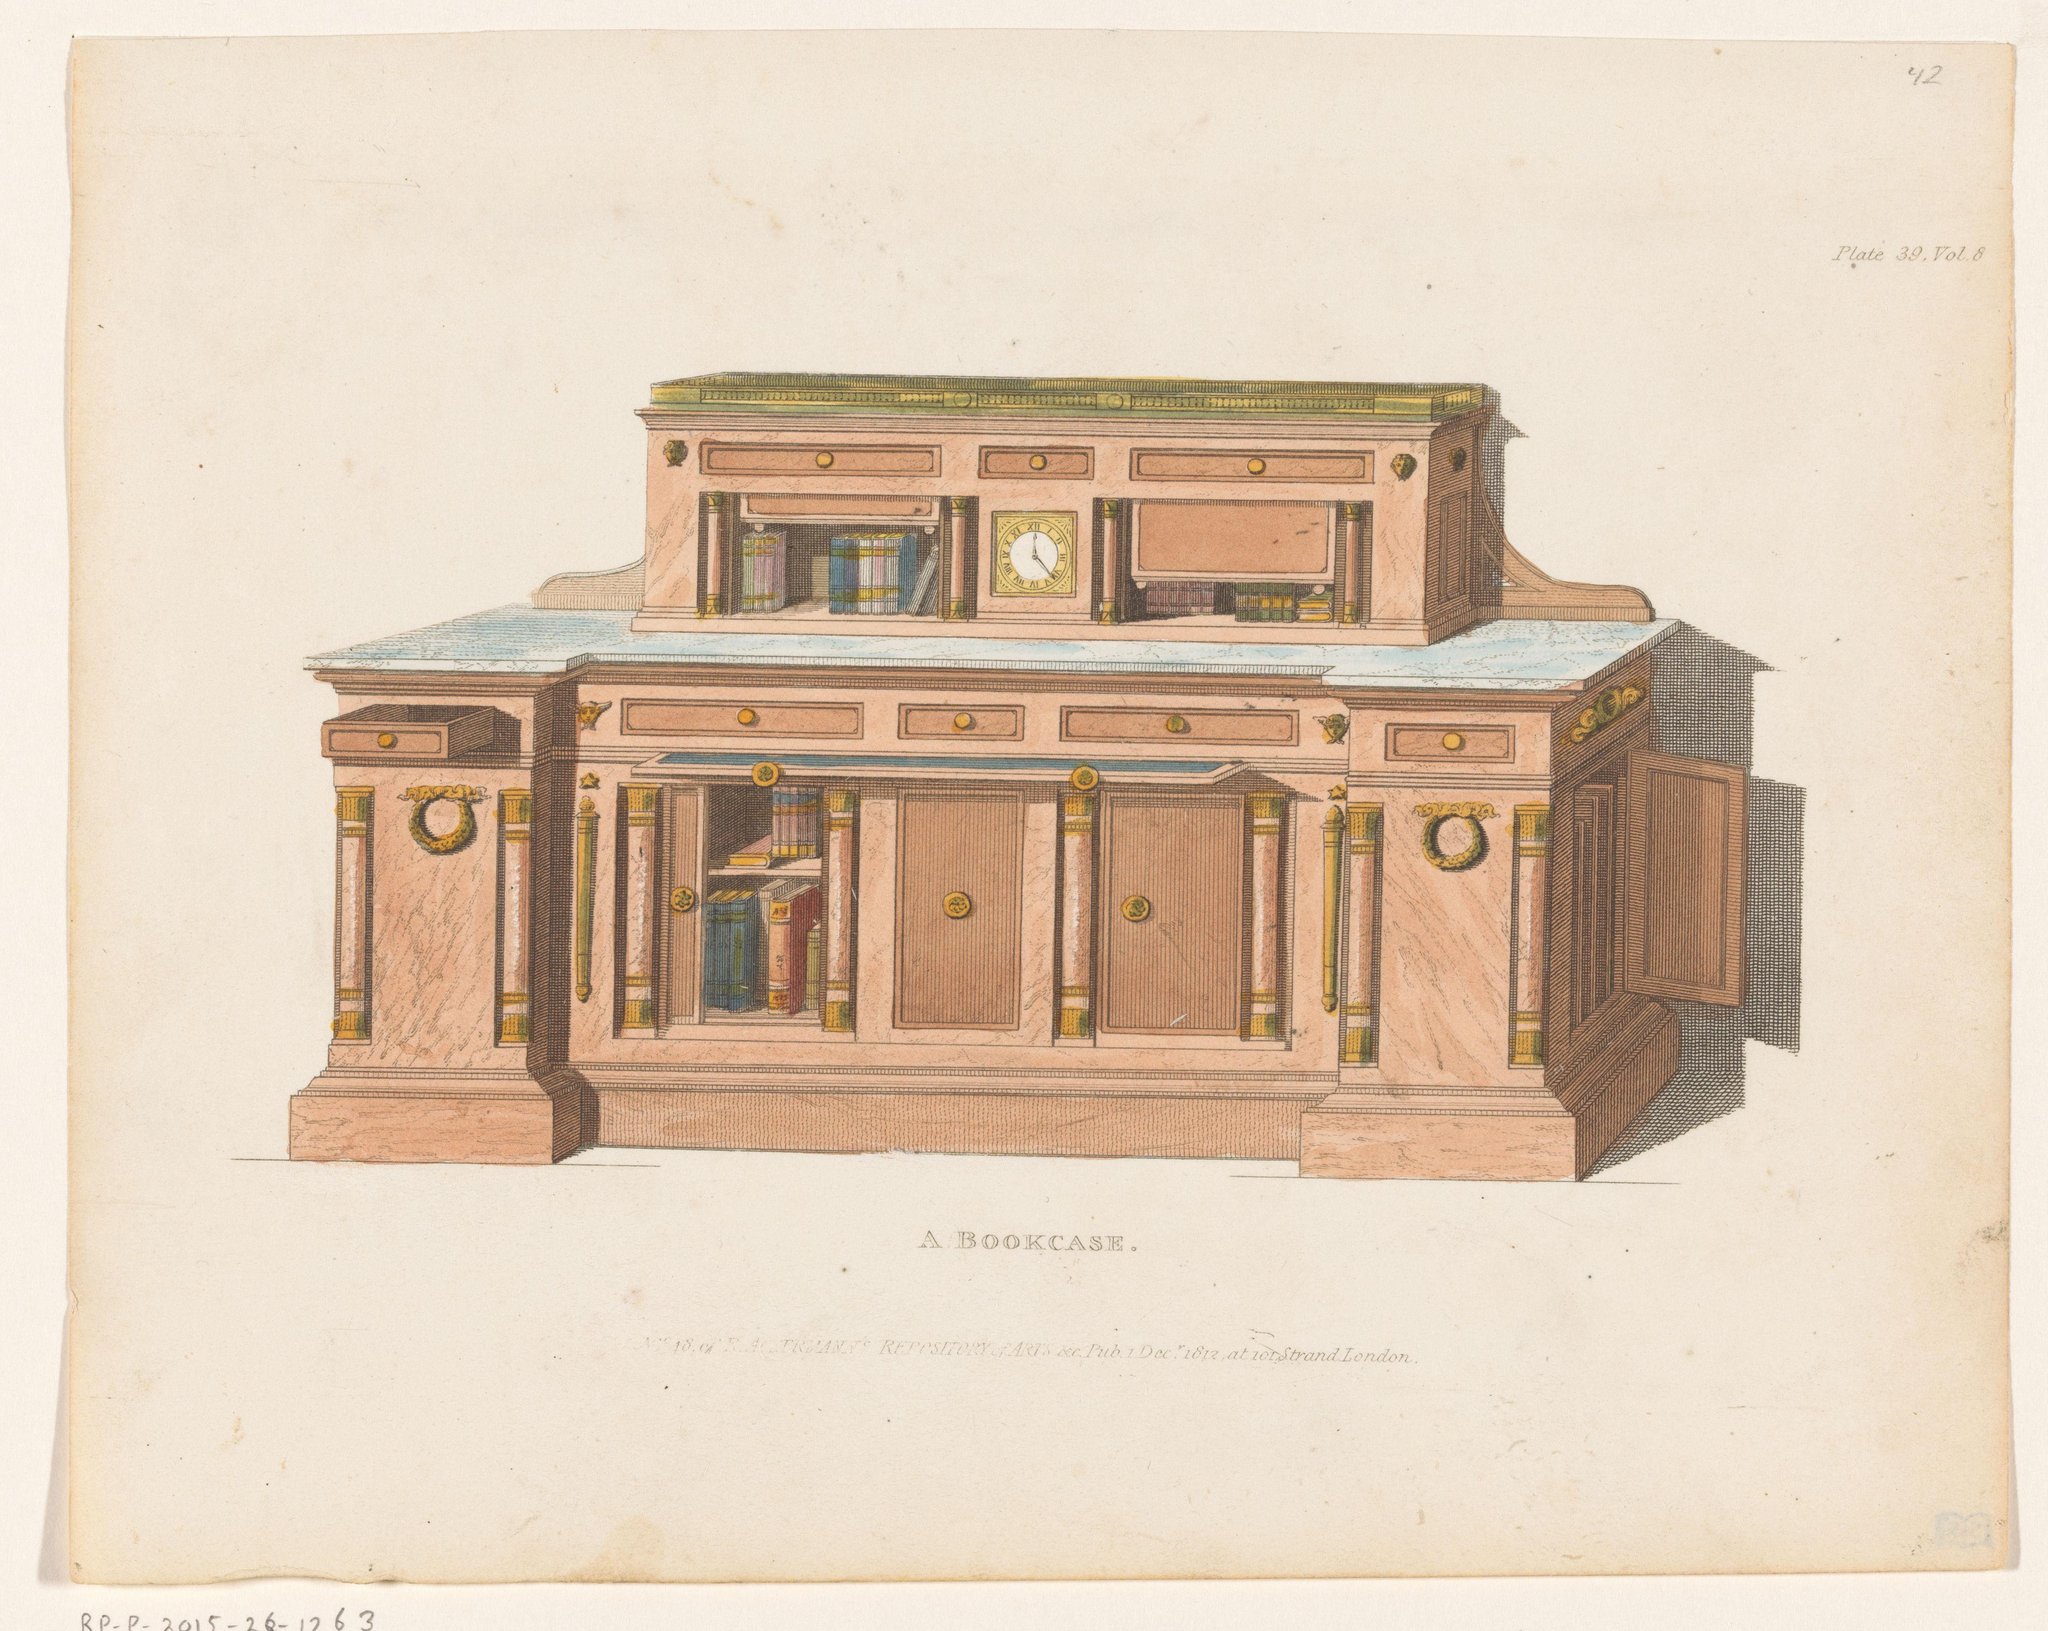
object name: print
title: Secretaire Bookcase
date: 1812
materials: paper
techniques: aquatint, hand coloring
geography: london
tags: bookshelves, furniture for storage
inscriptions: collector's mark: Lugt 4780, collector's mark: Lugt 2228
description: Prent afkomstig uit: Ackermann's Repository of arts, literature, commerce, manufactures, fashions, and politics.